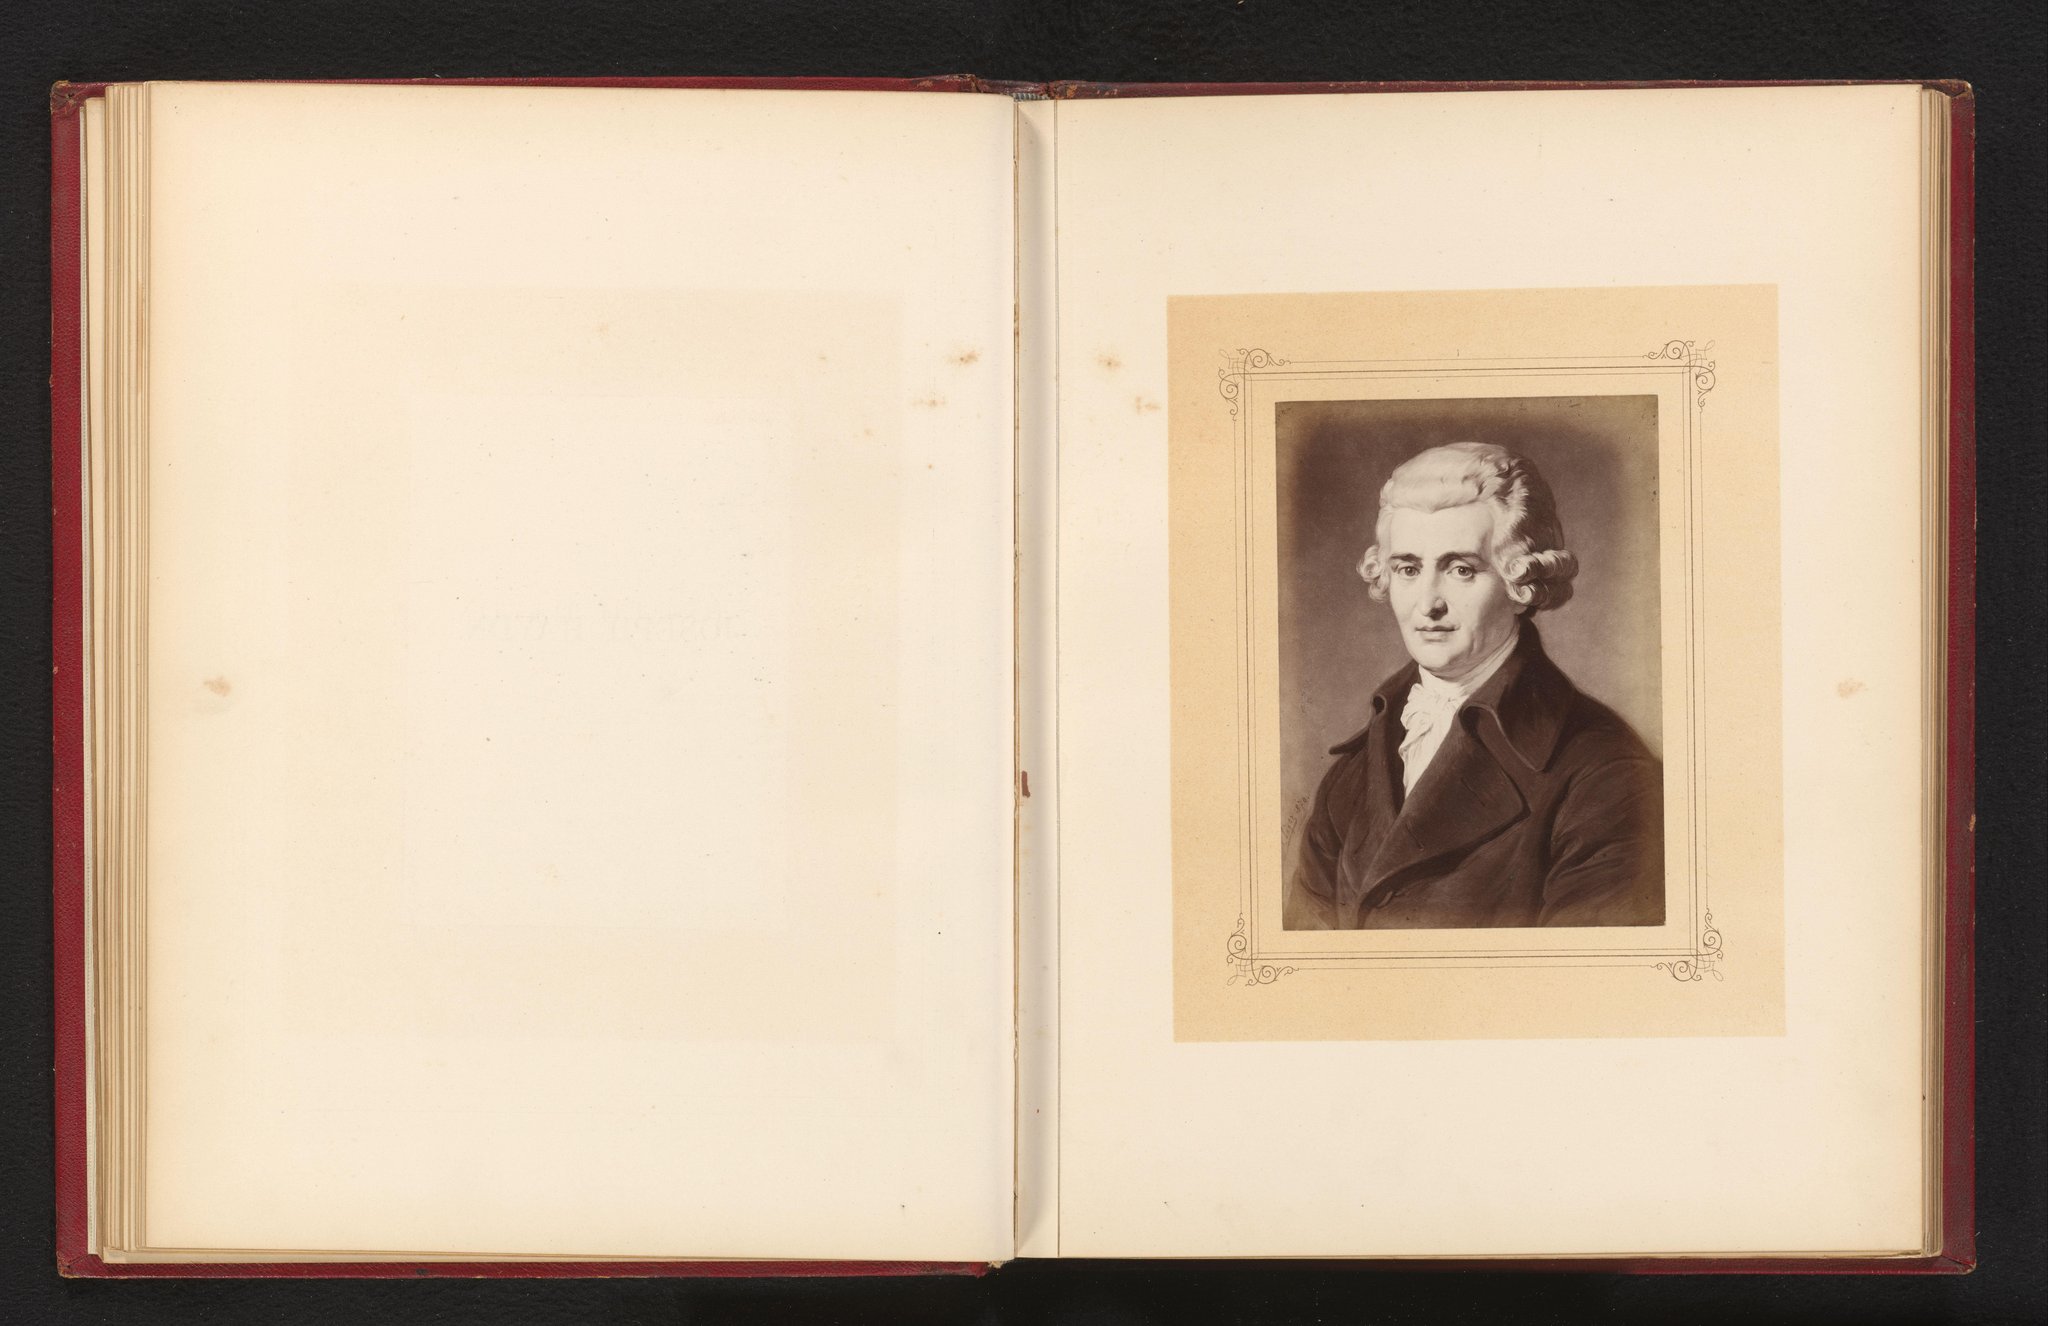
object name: reproduction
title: Fotoreproductie van een geschilderd portret van Joseph Haydn door Carl Jaeger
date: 1870-1872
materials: paper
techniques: albumen print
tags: portrait of composer, picture, painting